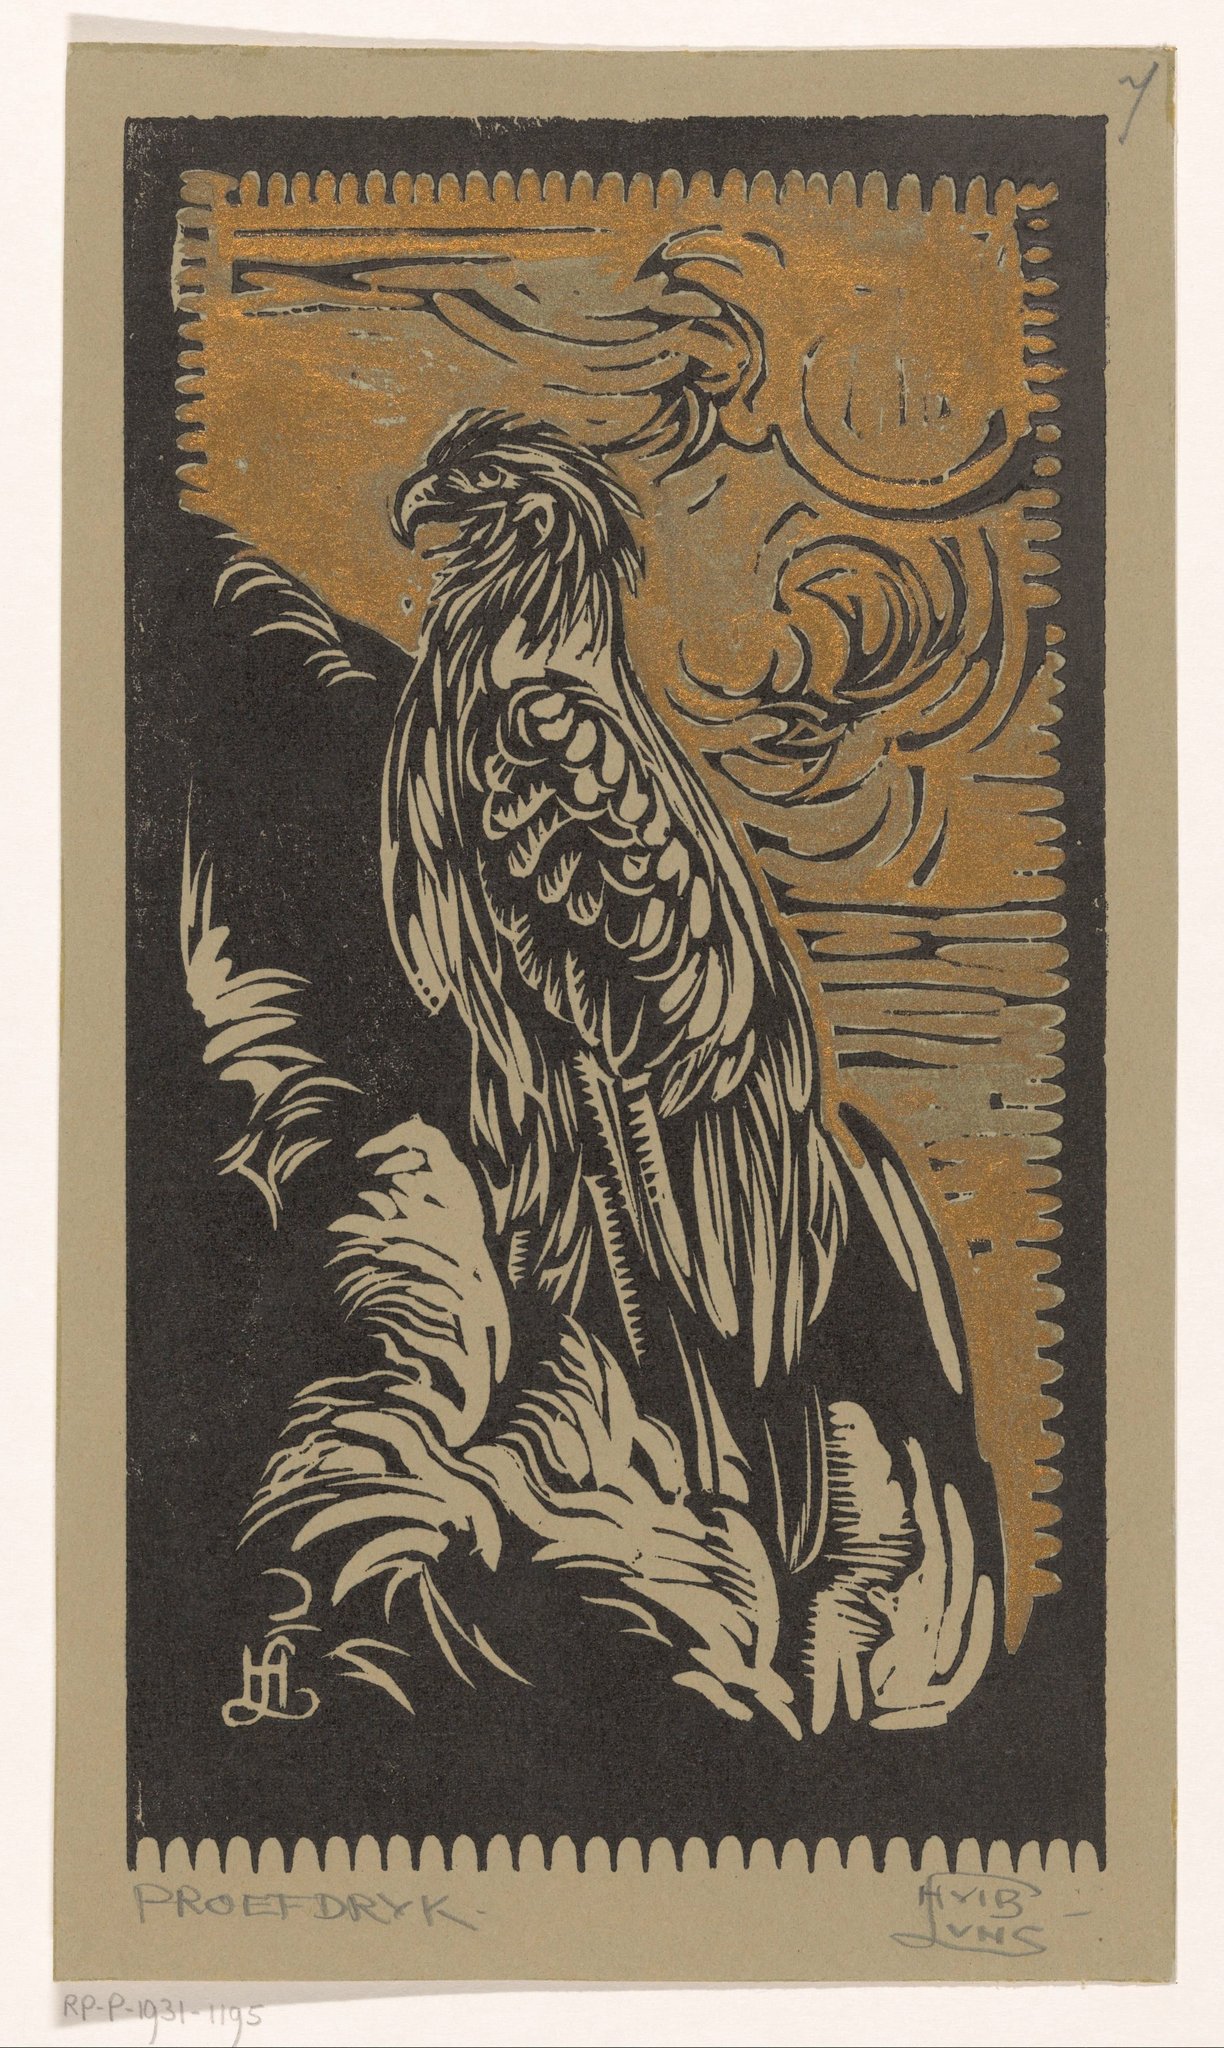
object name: print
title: Arend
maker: huib luns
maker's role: draughtsman, print maker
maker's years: 1881-1942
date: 1891-1931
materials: paper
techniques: woodcut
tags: predatory birds: eagle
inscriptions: collector's mark: Lugt 2228